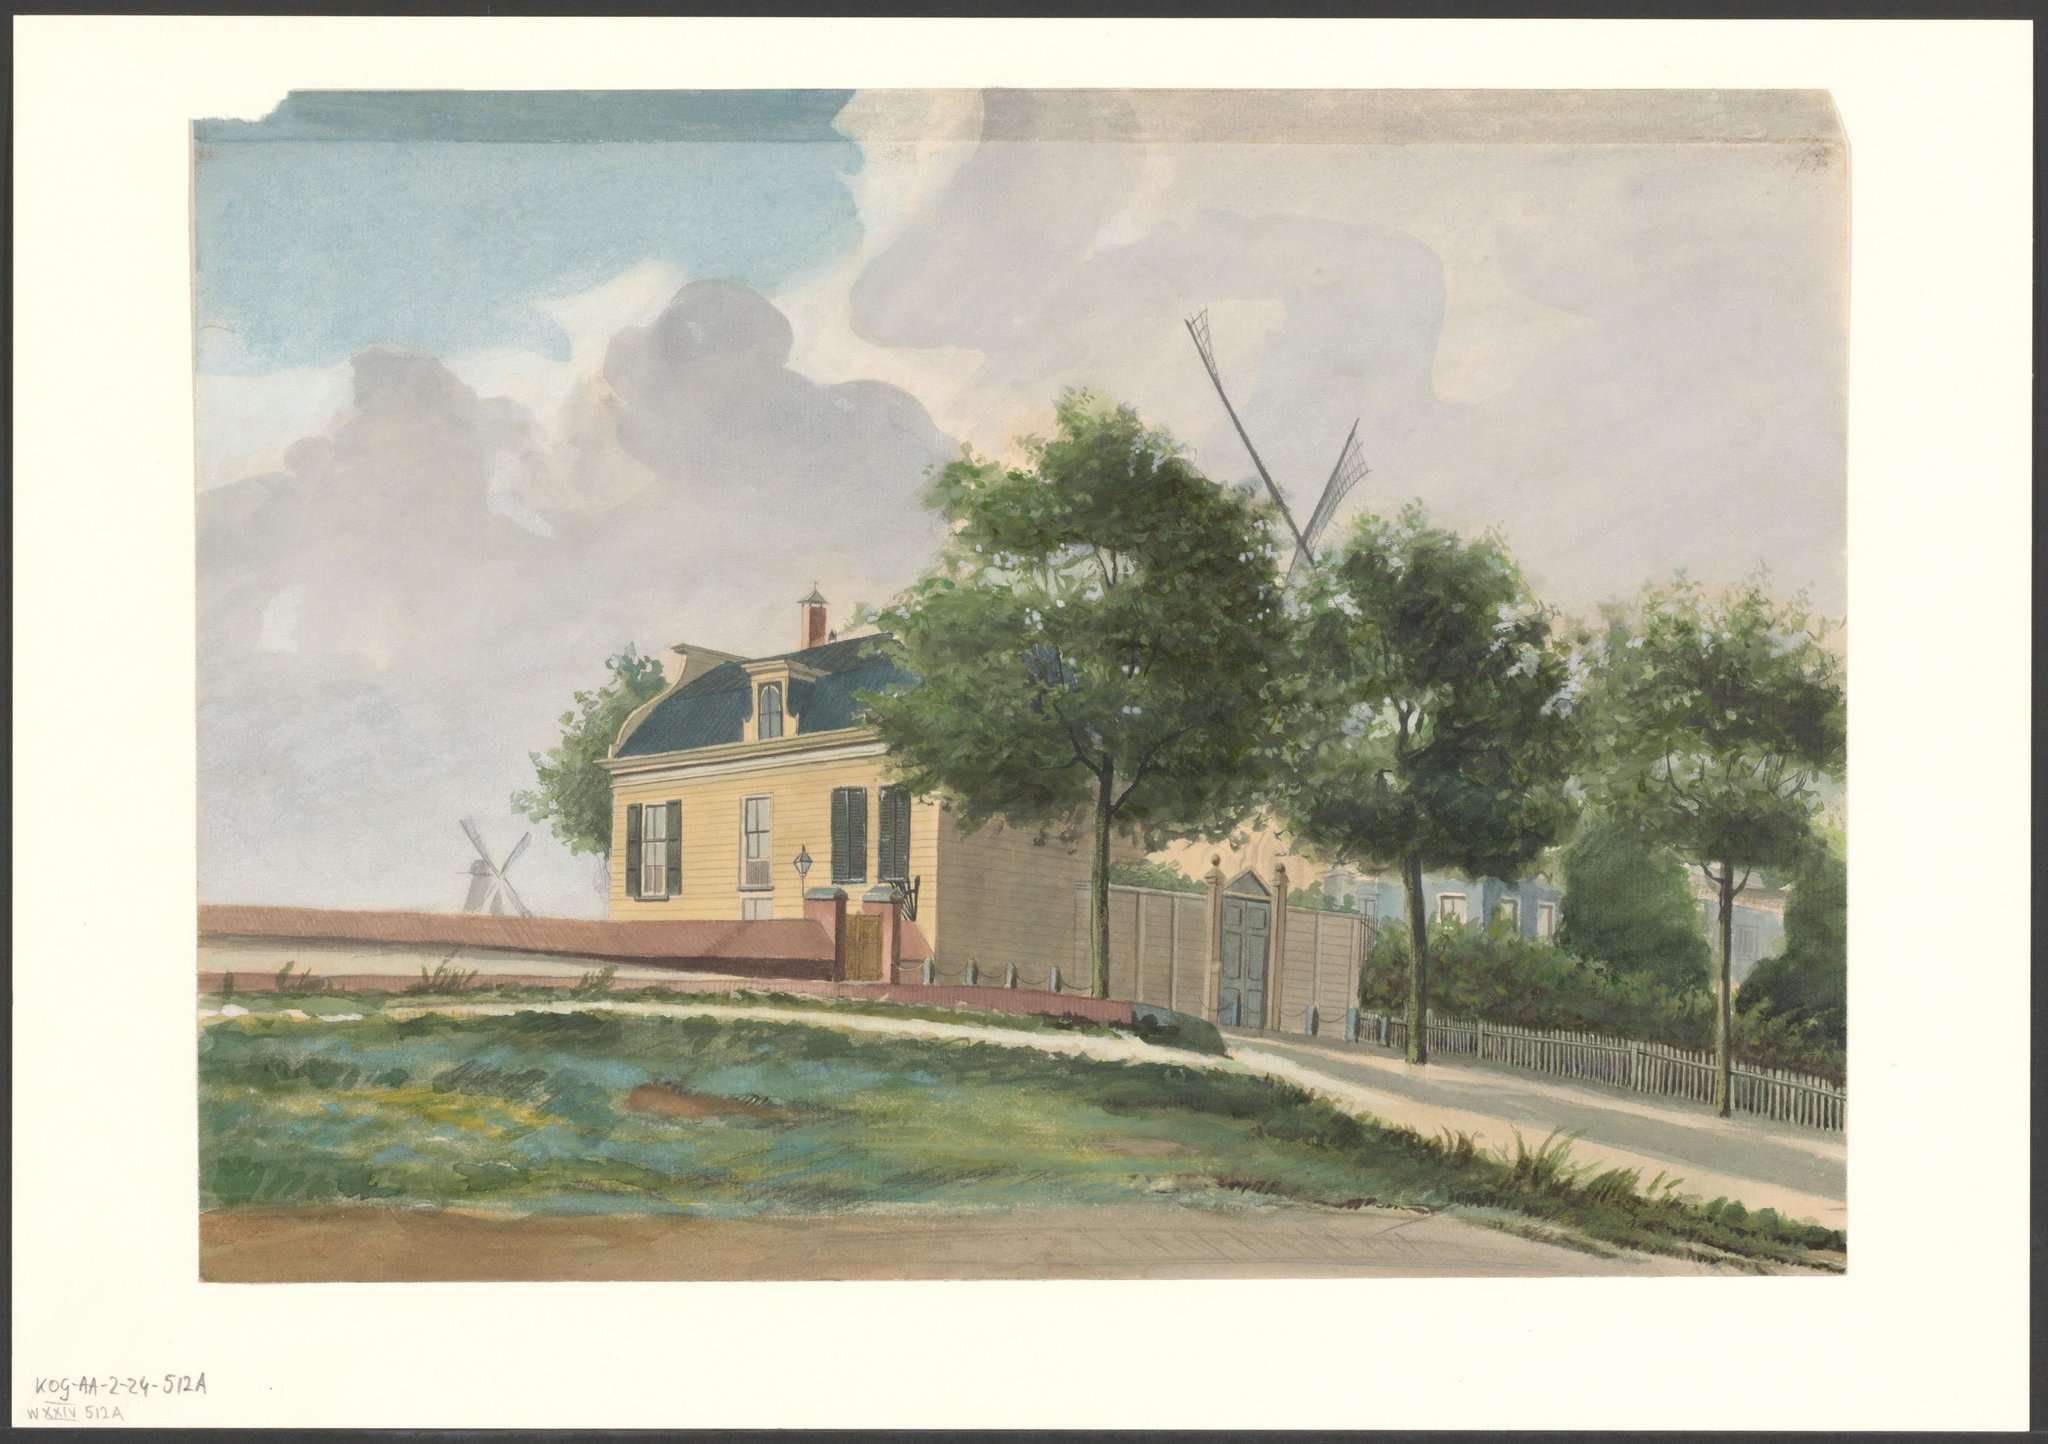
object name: drawing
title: Gezicht op de Singelgracht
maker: johan george lodewijk rieke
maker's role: draughtsman, print maker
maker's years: 1817-1898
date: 1827-1898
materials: gouache, ink, paper, pencil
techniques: brush, pen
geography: amsterdam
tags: city-view in general; 'veduta', windmill in landscape, farm or solitary house in landscape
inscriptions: collector's mark: Lugt 800a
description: Tekening binnen de Atlas Van Eck ingedeeld op wijknummer 24.